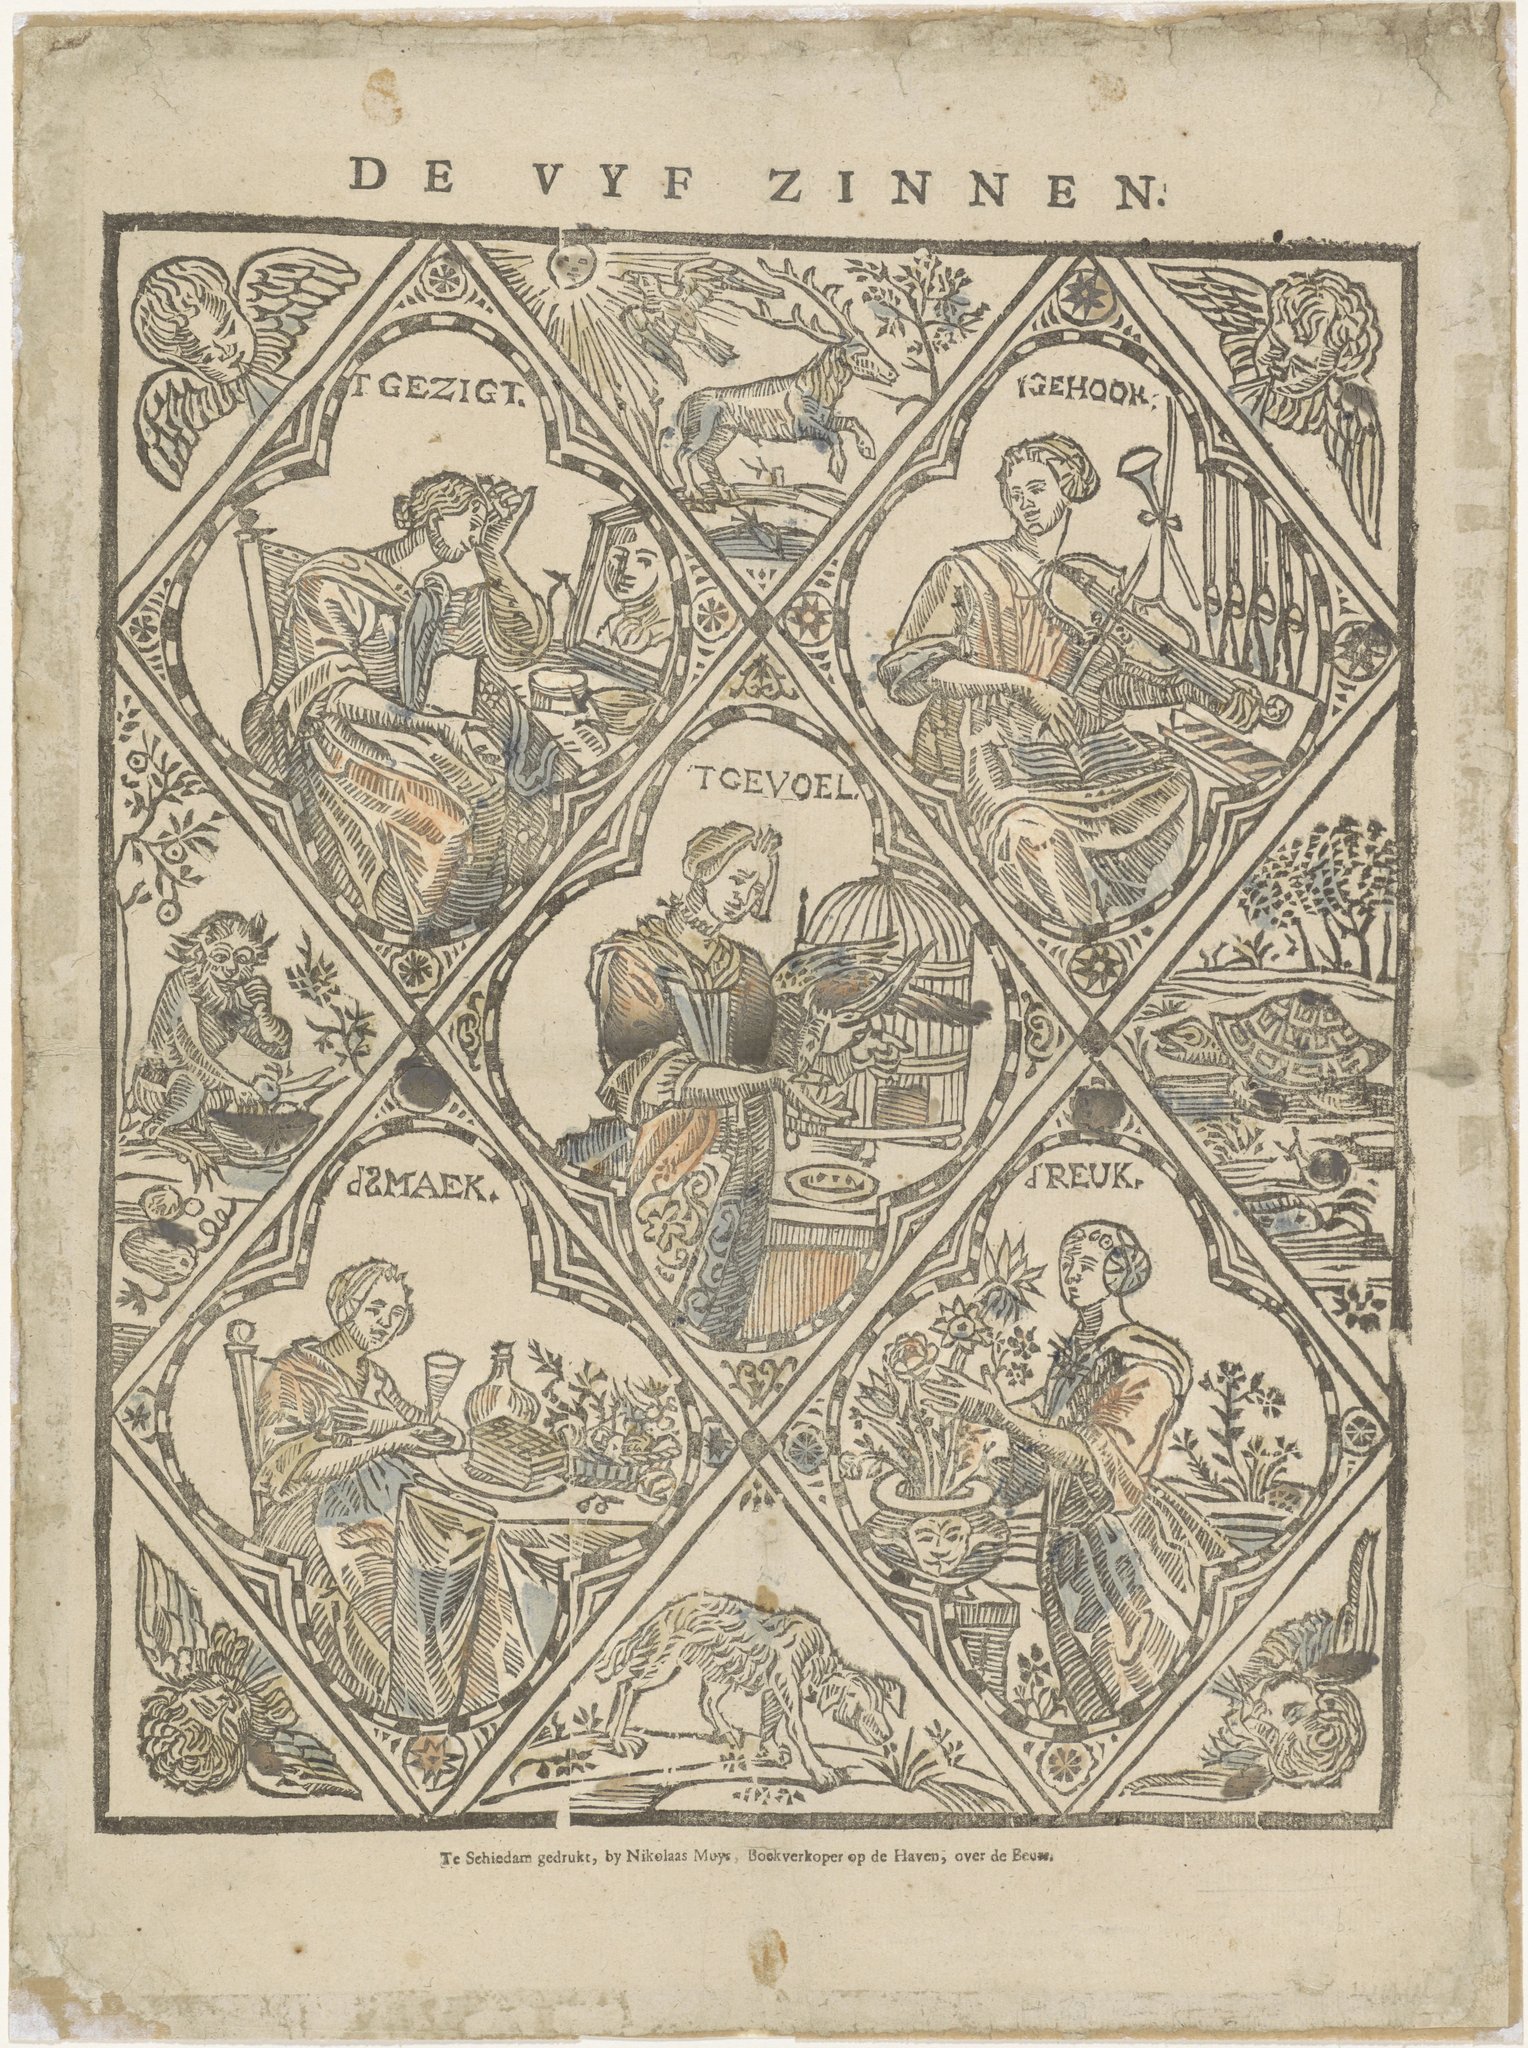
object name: print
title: De vijf zinnen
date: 1704-1757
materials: paper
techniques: colour, letterpress printing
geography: schiedam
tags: tortoises, turtles, monkeys, apes, the (five) senses, hoofed animals: stag, winds, dog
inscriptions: collector's mark: Lugt 2228, collector's mark: Lugt 2760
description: Personificaties van de vijf zintuigen in vierpassen. In de vier hoeken cherubijnen die wind blazen. Tussen de voorstellingen een aap, een hert, een schildpad en een hond.